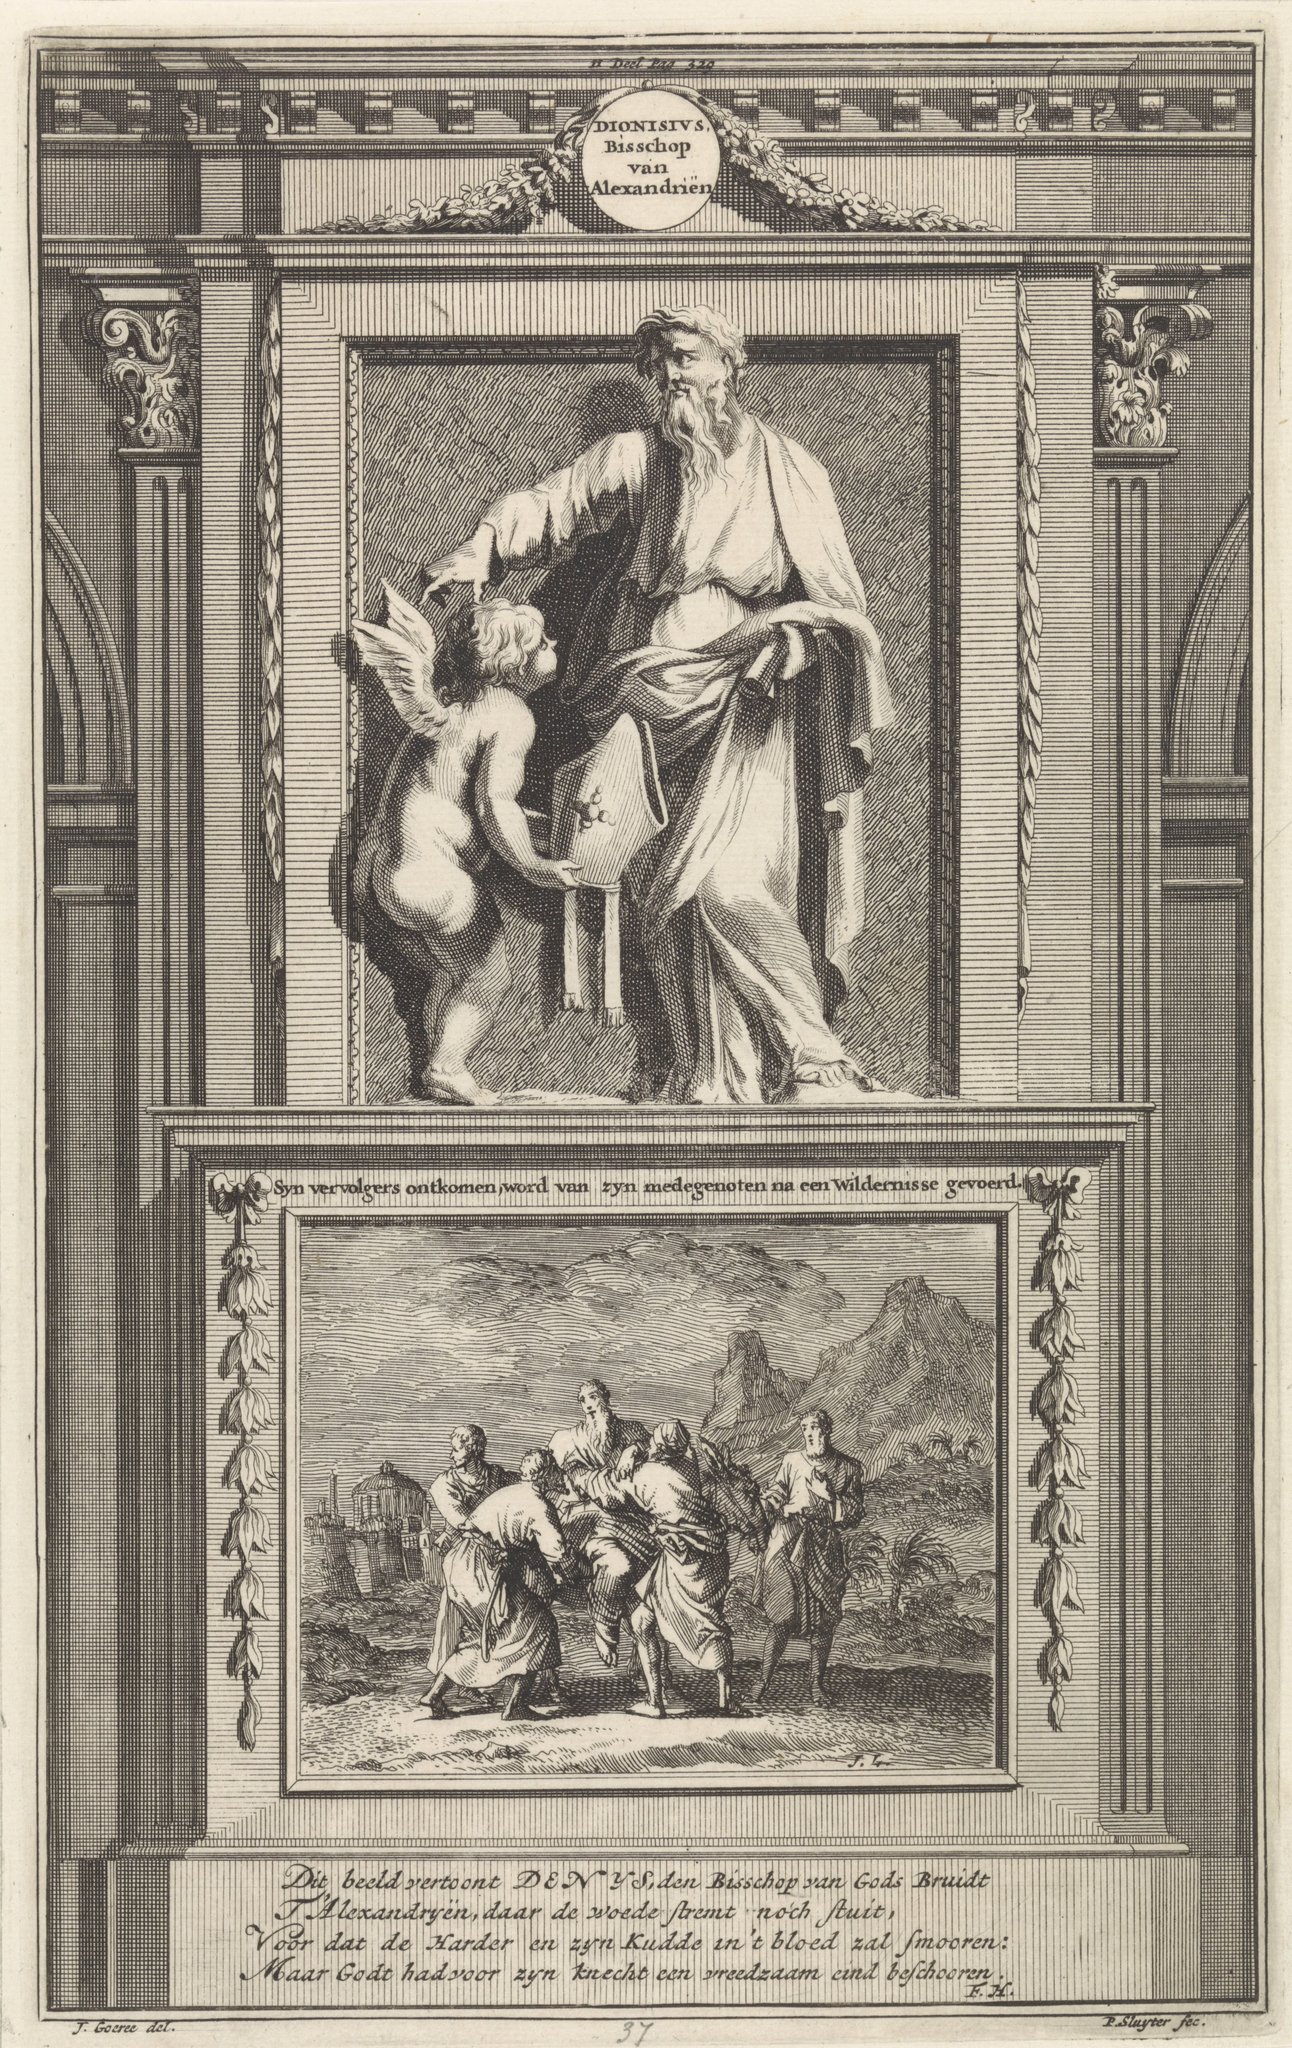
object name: print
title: Dionisius, bisschop van Alexandriën Syn vervolgers ontkomen, word van zyn medegenoten na een Wildernisse gevoerd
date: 1698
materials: paper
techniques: engraving, etching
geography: amsterdam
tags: riding a horse, ass, or mule; rider, horseman, male saints (dionysius of alexandria)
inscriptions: collector's mark: Lugt 2228, number: ‘37’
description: De heilige kerkvader Dionysius van Alexandrië krijgt door een engel de bisschopsmijter aangeboden. Dionysius staat op een sokkel. Op de voorzijde de scène waarin hij door vier ouderlingen op een ezel wordt gezet om hem naar de Libische woestijn te brengen. Prent middenboven gemerkt: II Deel Pag 329.